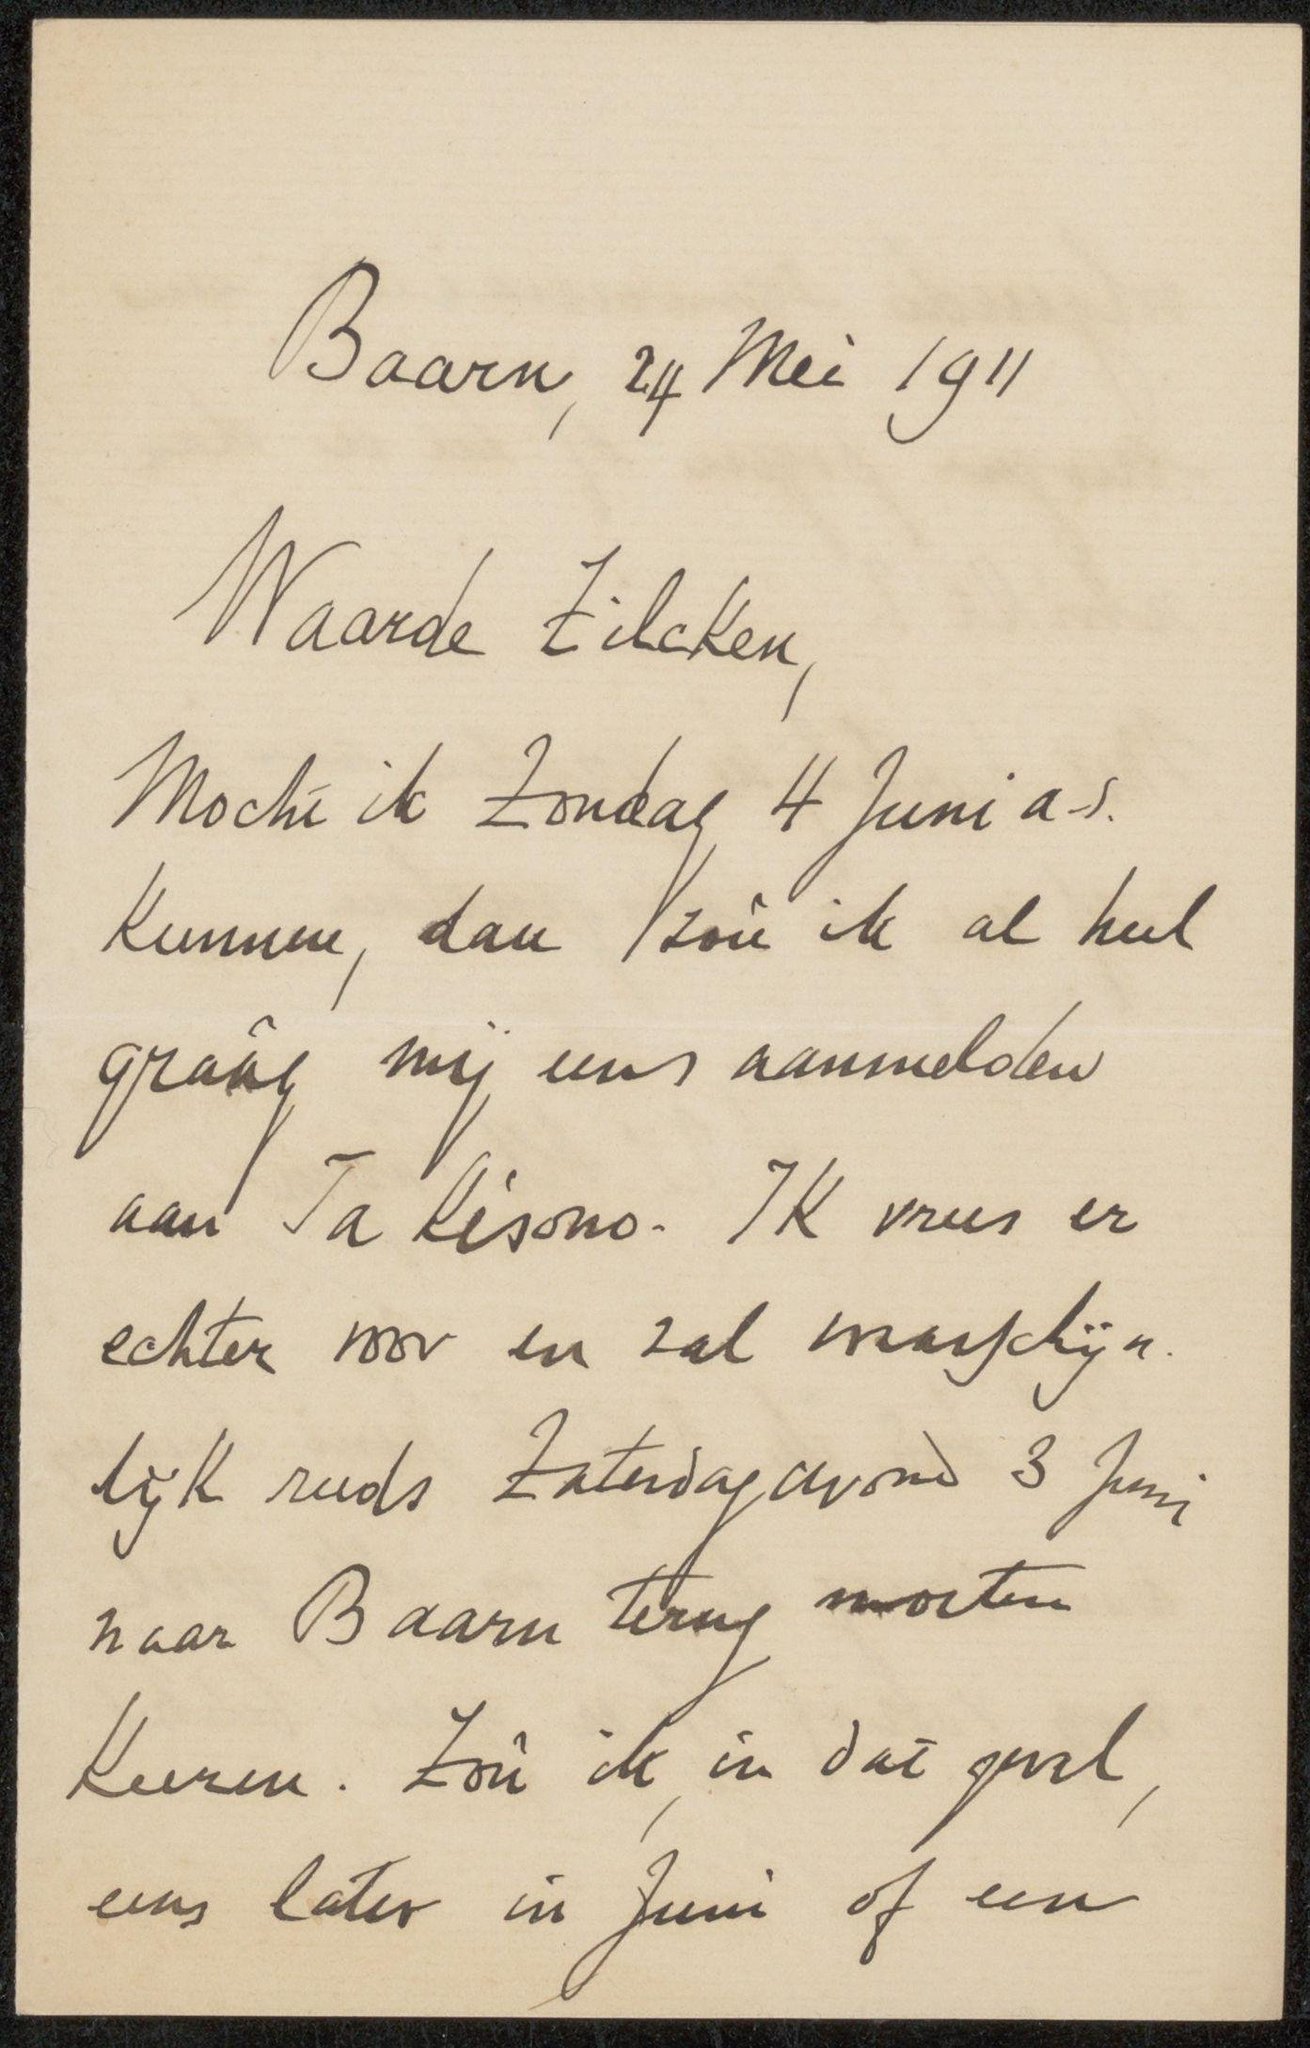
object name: letter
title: Brief aan Philip Zilcken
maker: karel johan lodewijk alberdingk thijm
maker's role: criticus, prozaschrijver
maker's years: 1864-1952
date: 1911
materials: ink, paper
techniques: pen, writing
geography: baarn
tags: painter, draughtsman, philip zilcken, the hague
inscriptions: collector's mark: ‘RPK’